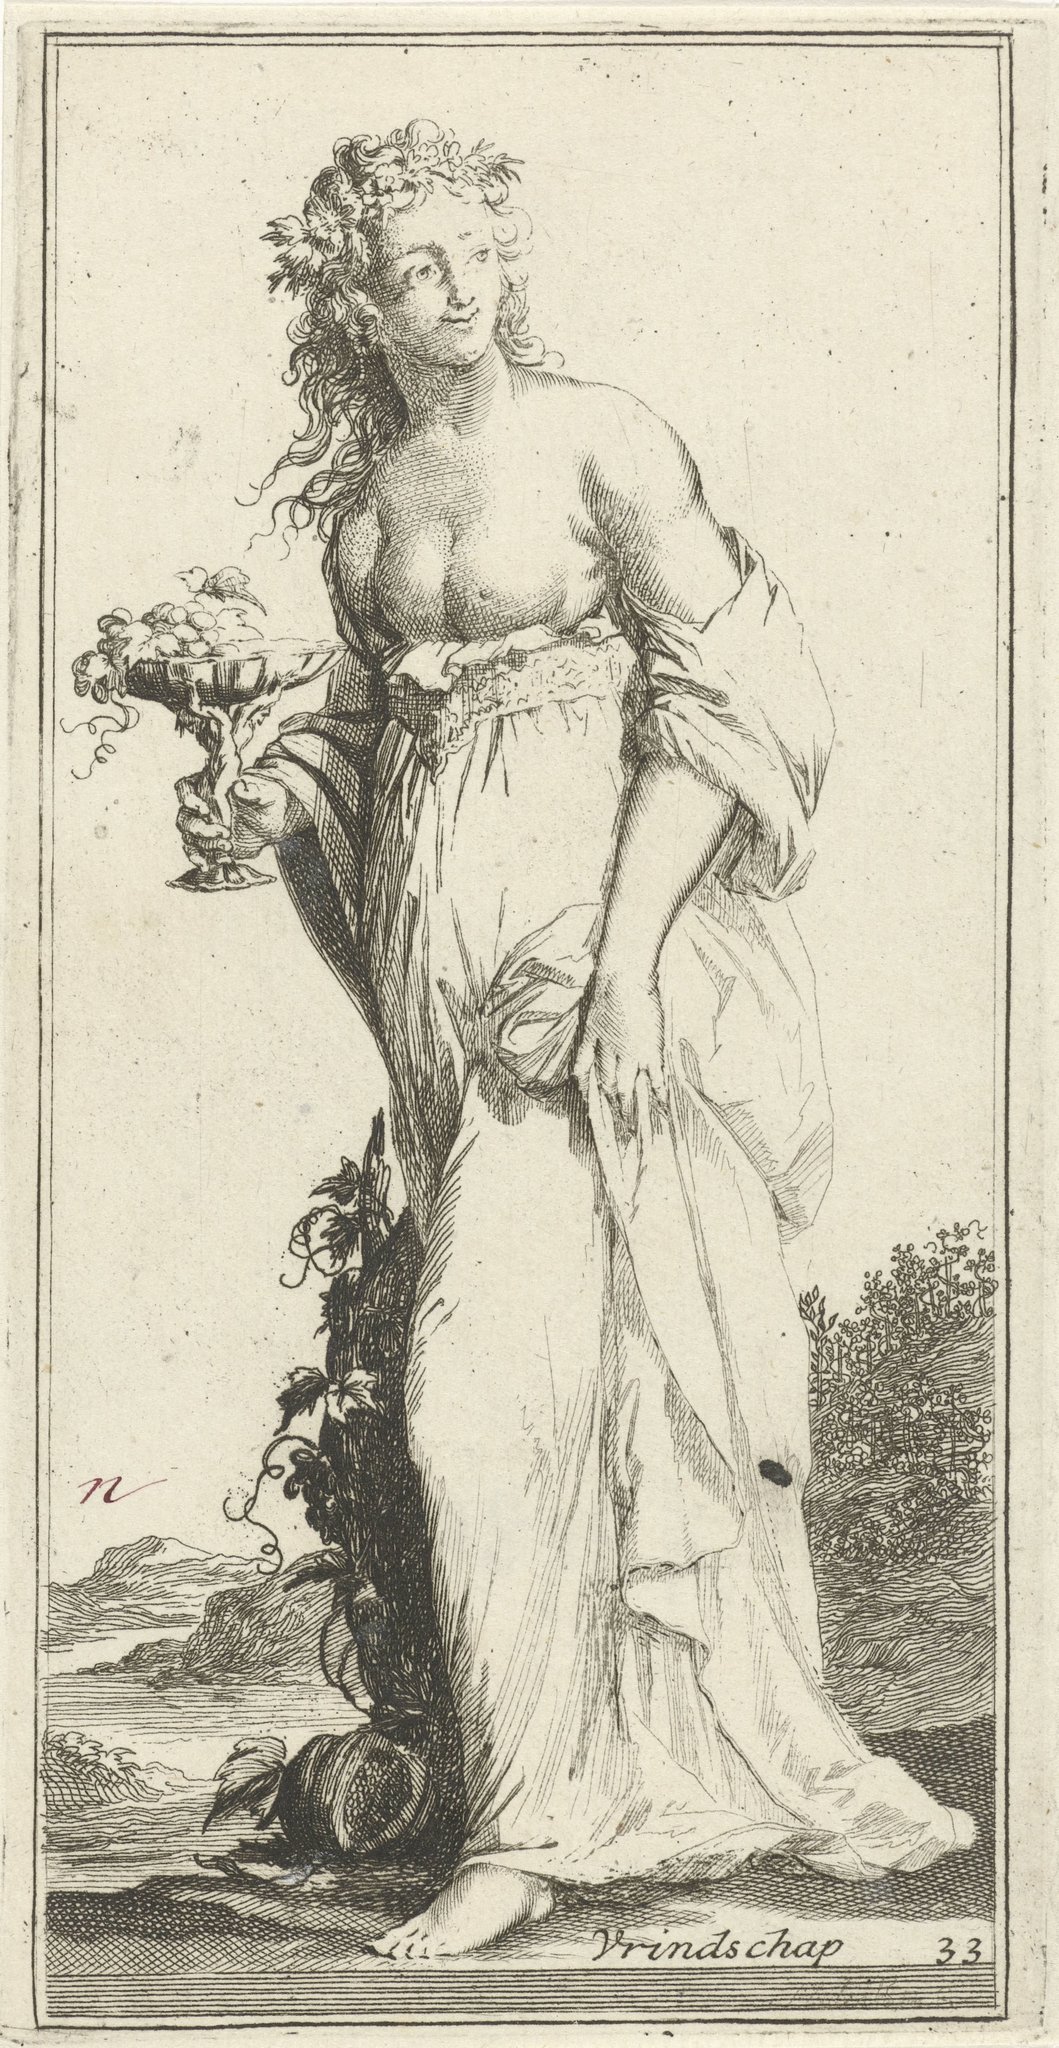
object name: print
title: Vrindschap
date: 1710-1719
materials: paper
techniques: engraving, etching, pen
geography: amsterdam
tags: friendship; 'amicitia' (ripa) (+ abstract concept represented by female figure), bowl, fruits: pumpkin, grape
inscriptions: collector's mark: Lugt 2228, inscription: ‘N’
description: Een vrouwfiguur als personificatie van vriendschap, met in haar hand een schaal met druiven. Op de grond bij haar voet een pompoen. Prent uit een serie van 41 zinnebeelden.